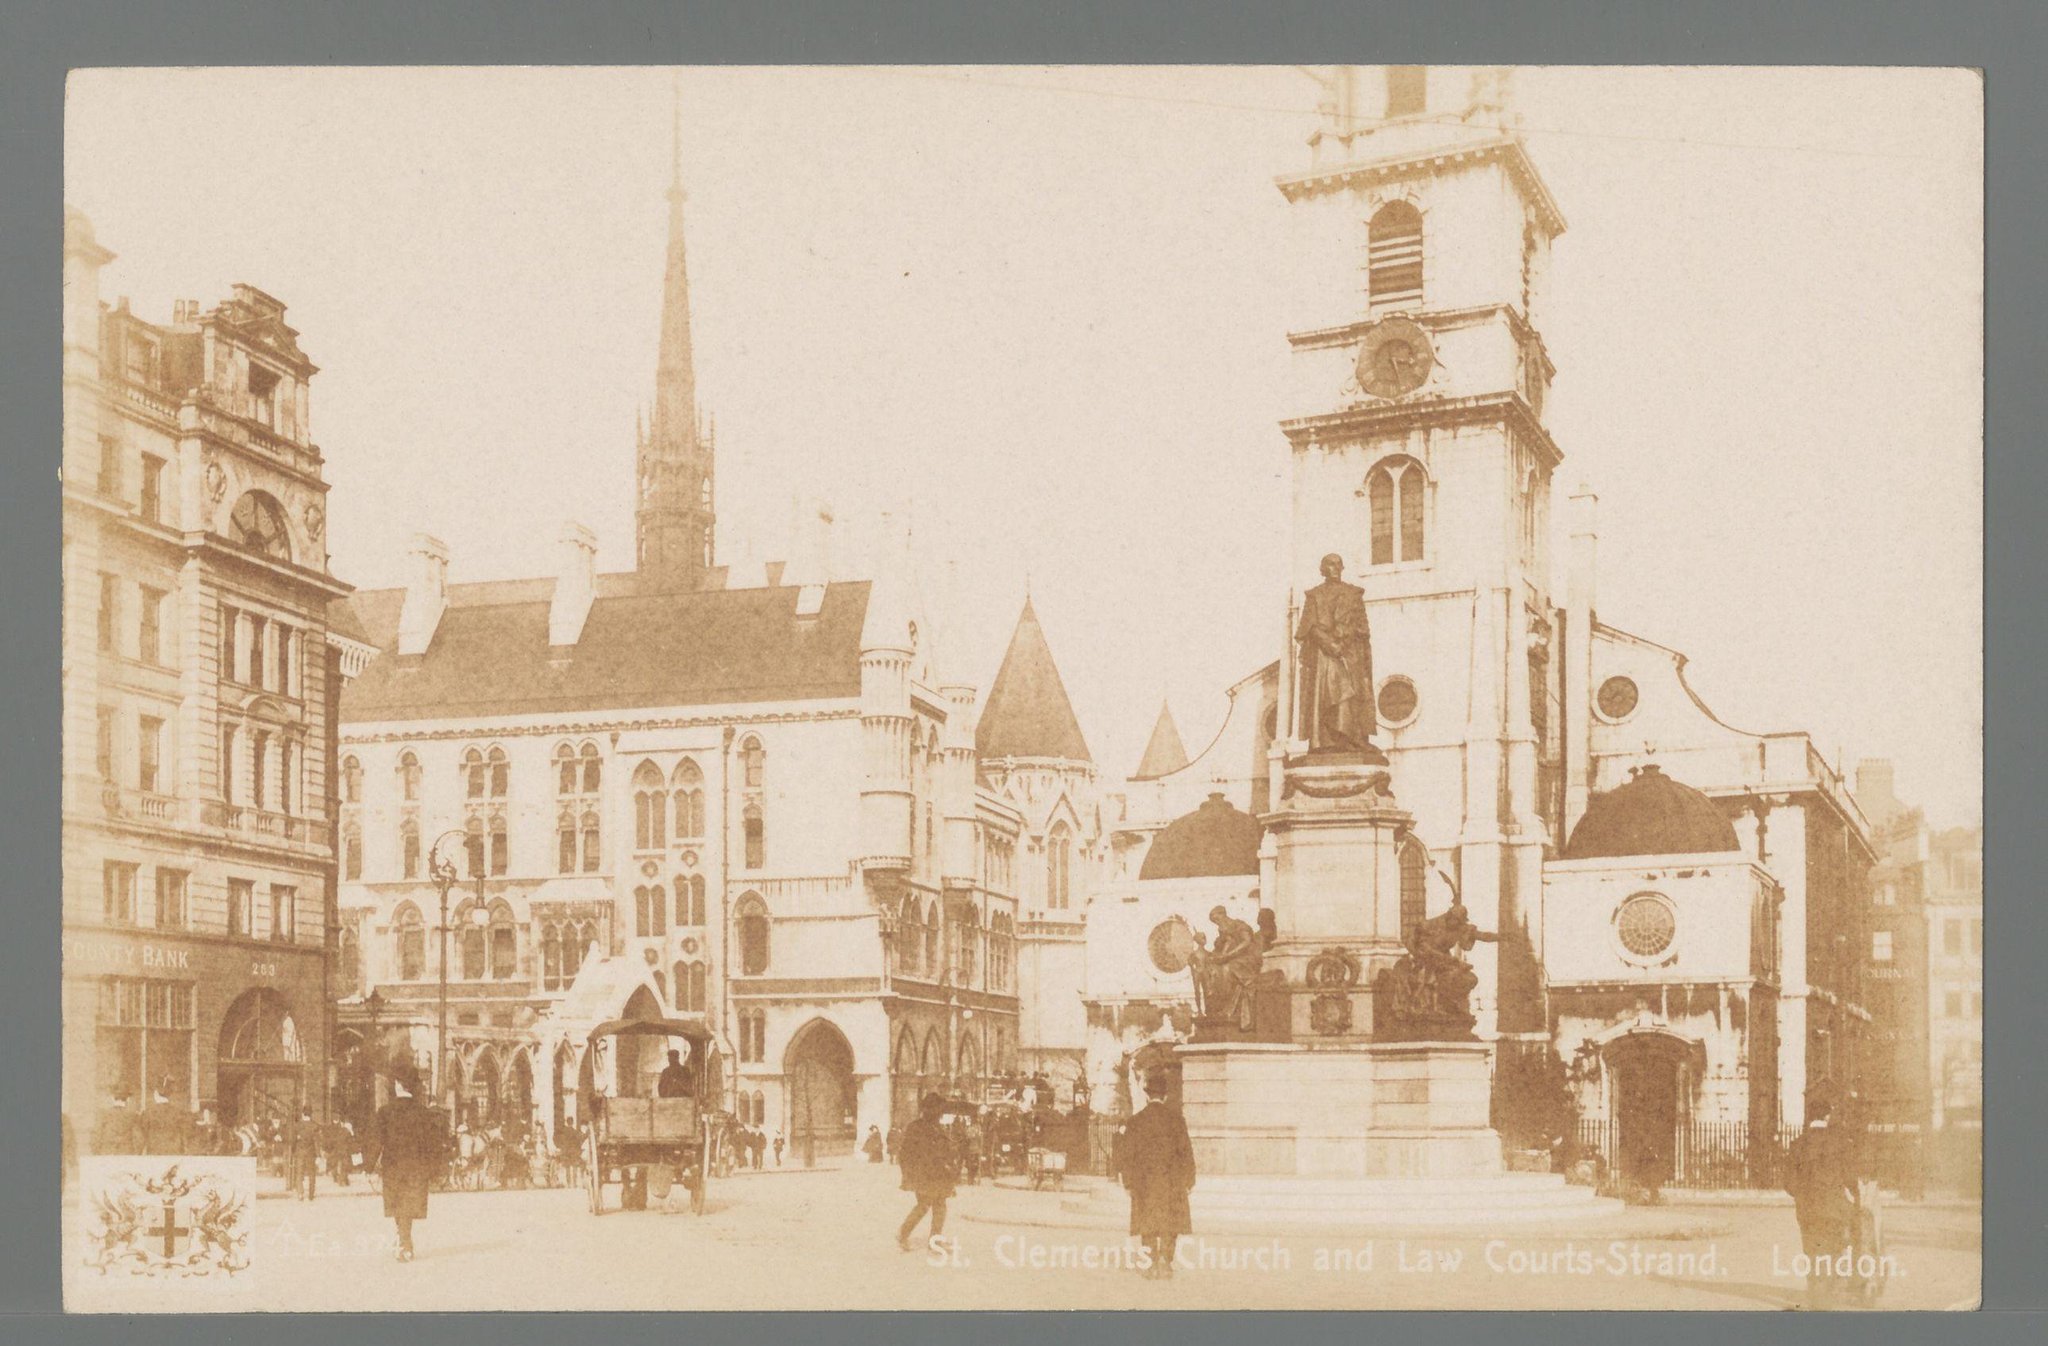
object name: ansichtkaart, prentbriefkaart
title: St. Clements' Church and Law Courts-Strand. London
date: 1902-1940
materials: paper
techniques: gelatin silver print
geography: saxony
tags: square, place, circus, etc., coat of arms (as symbol of the state, etc.), church (exterior), monument, statue